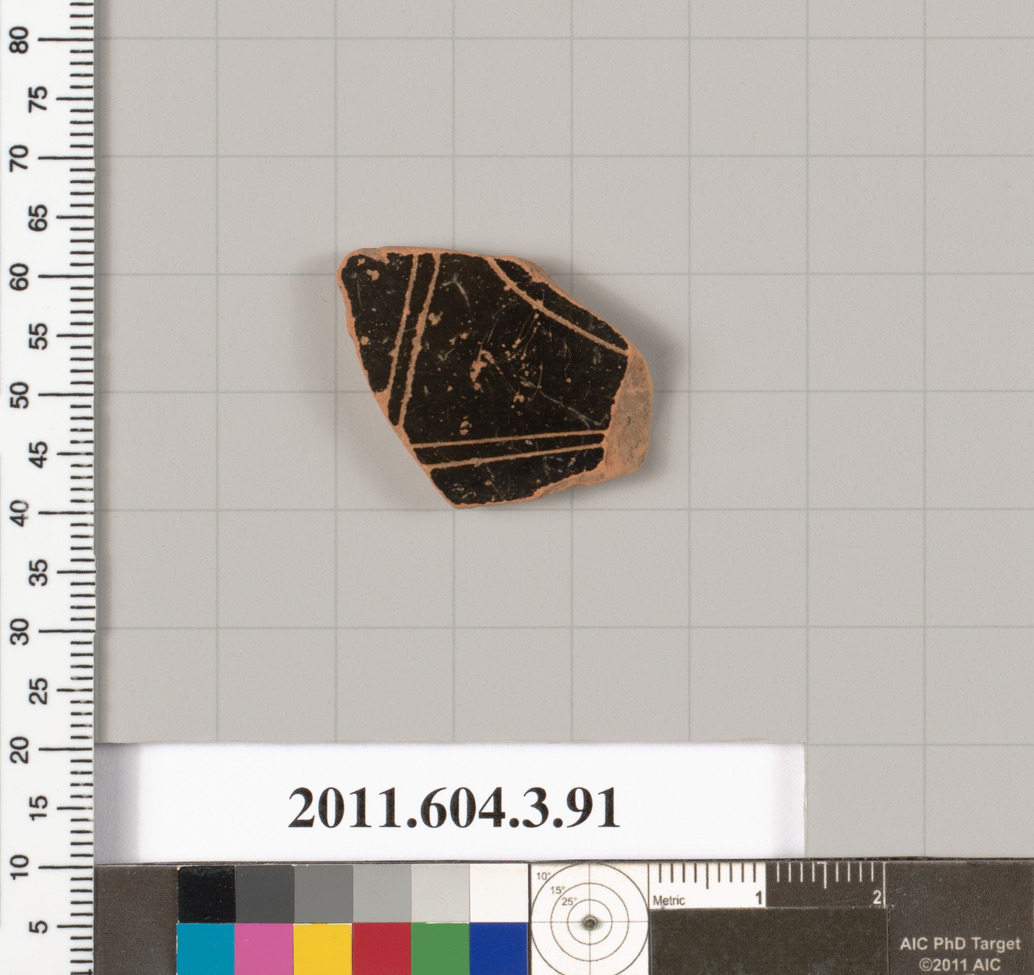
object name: amphora fragment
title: Terracotta fragment of an amphora (jar)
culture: greek, attic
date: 550-501 BCE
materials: terracotta